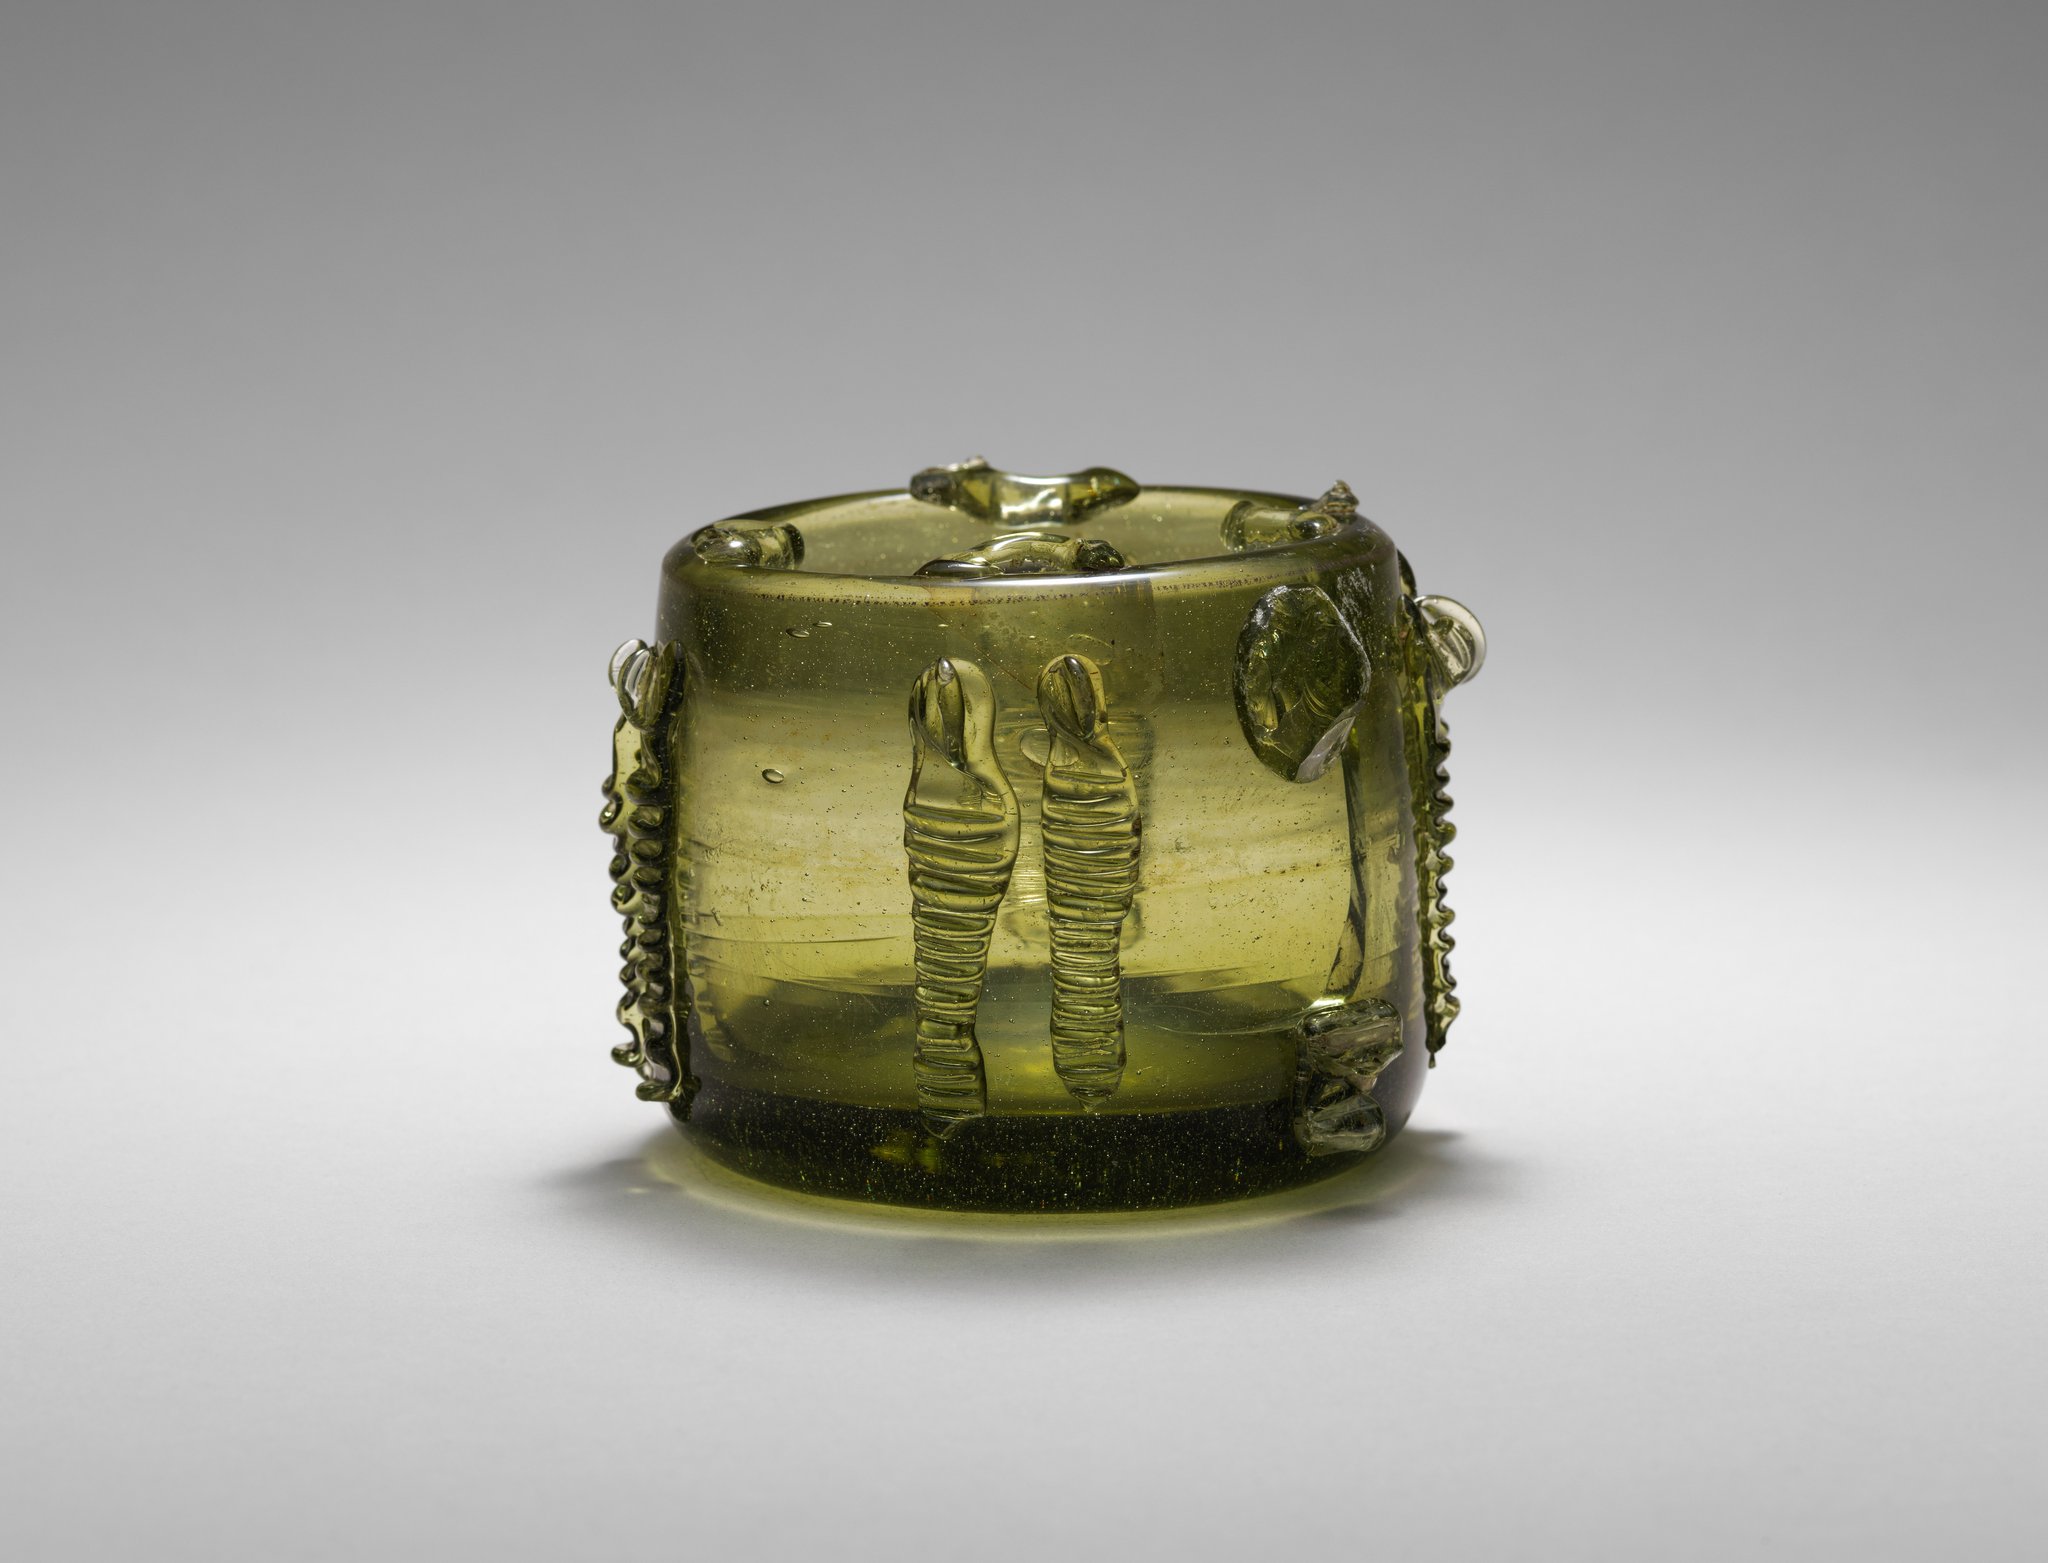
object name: bowl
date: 1701-1800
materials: glass